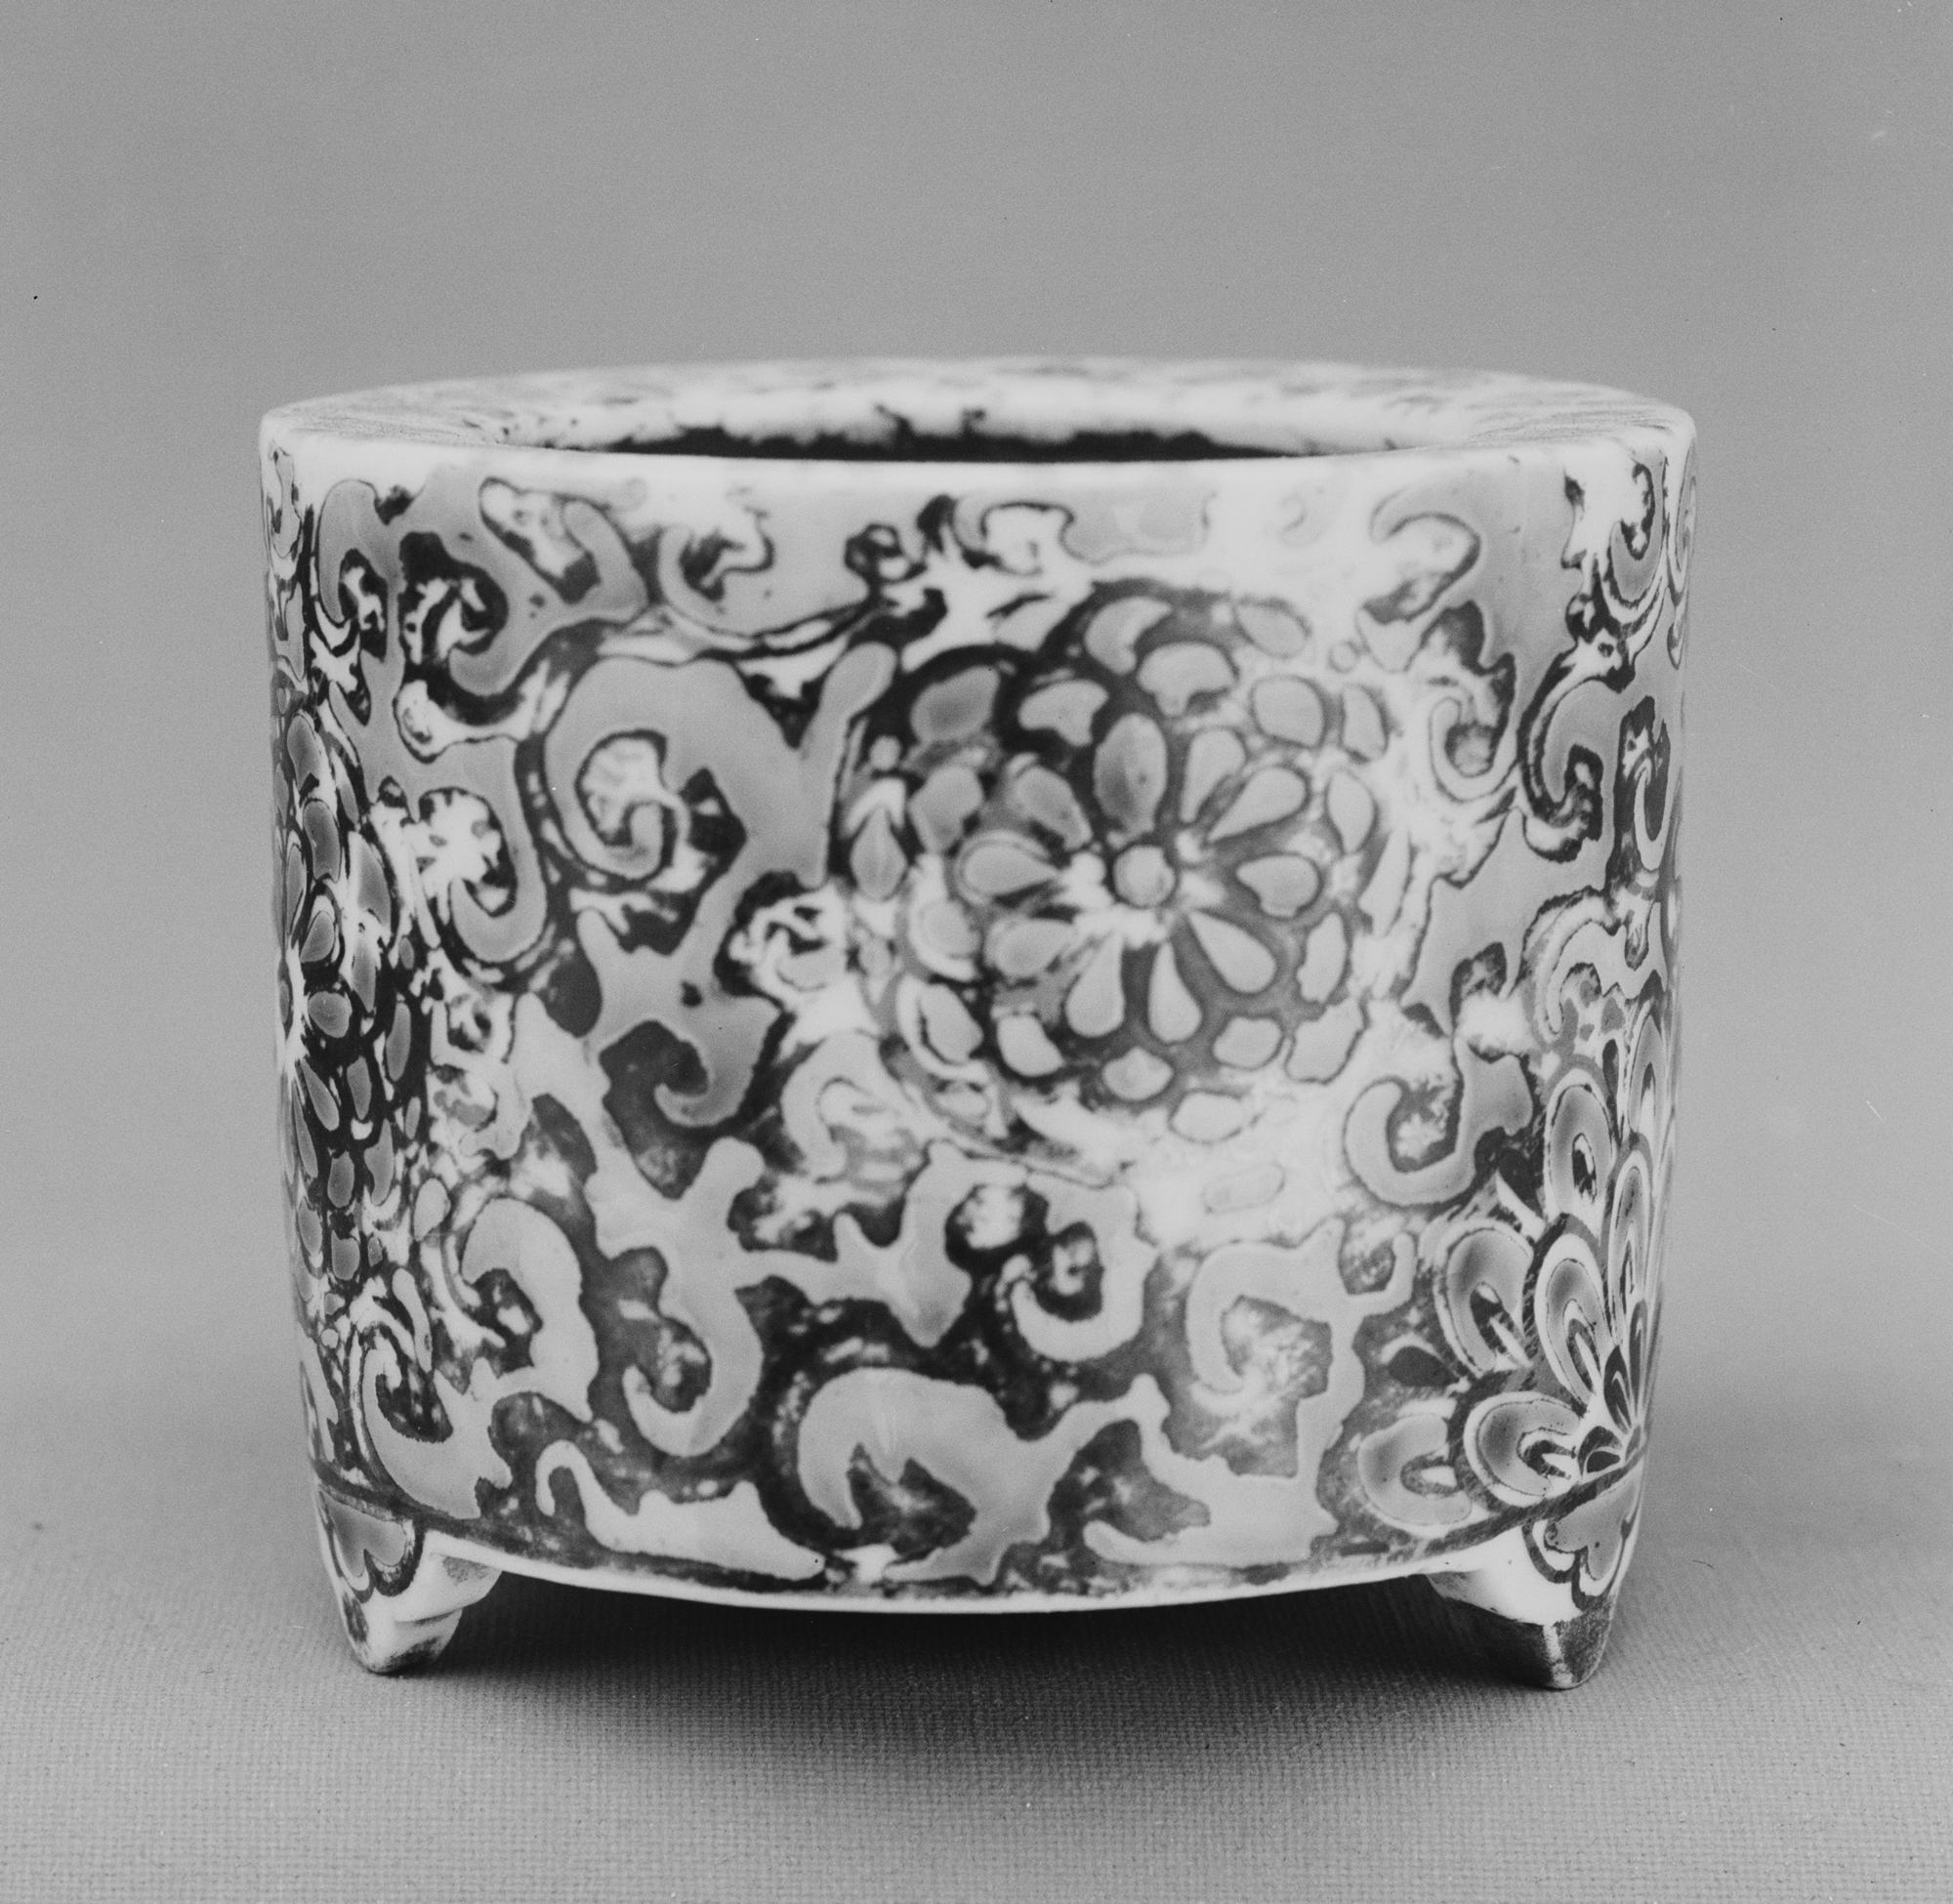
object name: incense burner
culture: japanese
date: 1700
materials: enamel, gold, porcelain